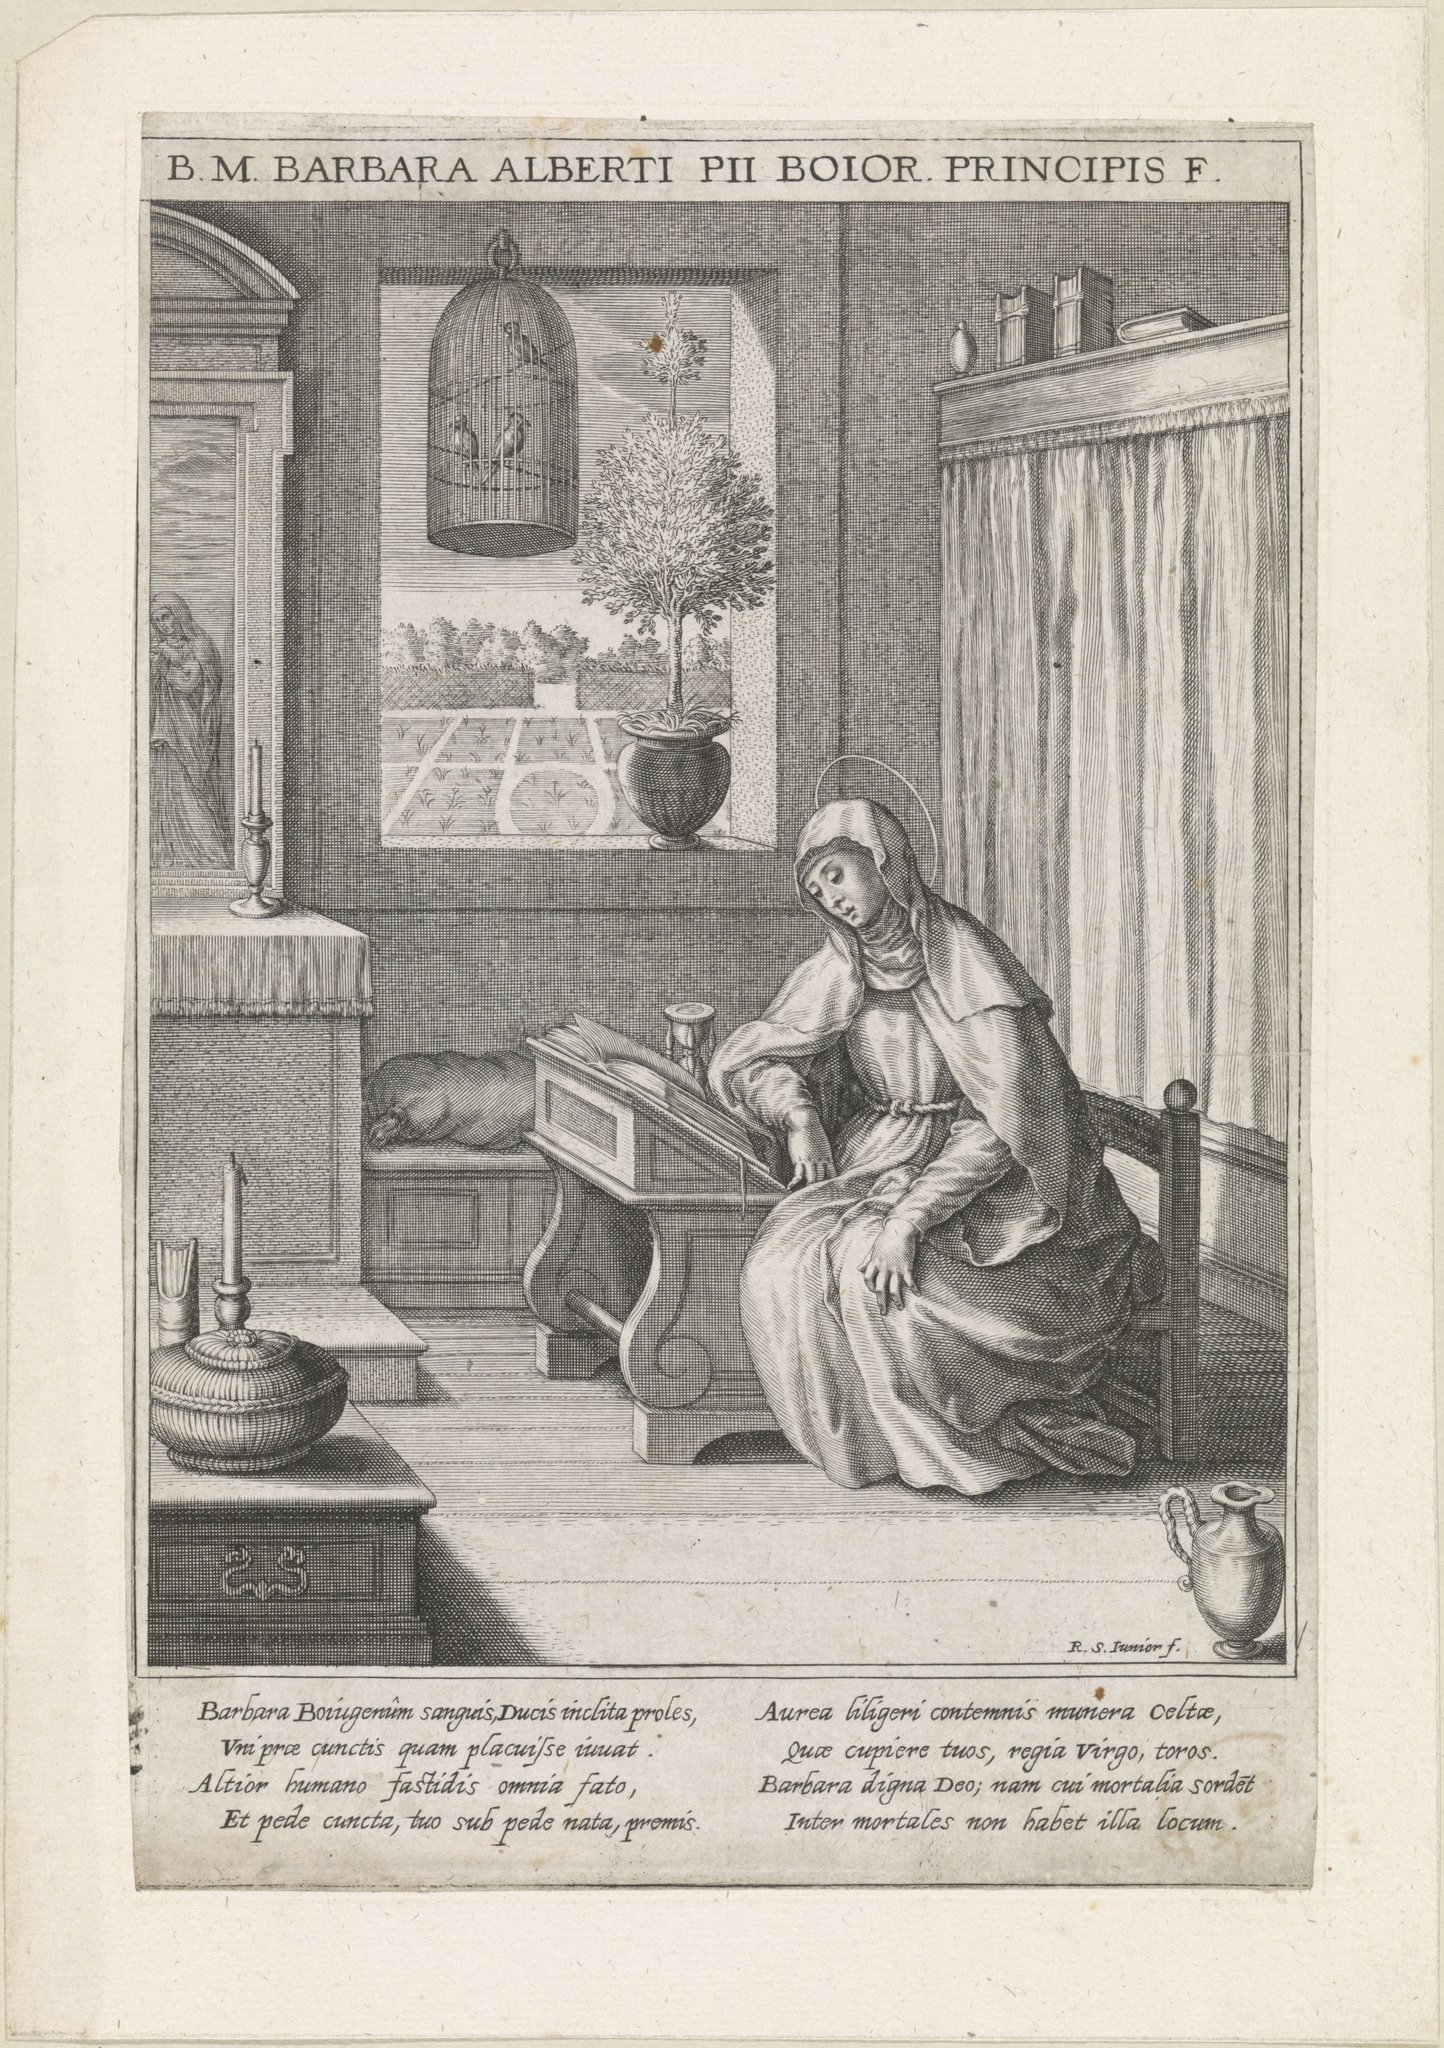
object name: print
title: B.M. Barbara Alberti PII Boior. Principis F.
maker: raphaël sadeler (ii)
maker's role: print maker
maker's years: 1584-1632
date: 1627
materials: paper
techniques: engraving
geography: munich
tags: reading, nun(s), cloisters ~ monastery, bird in a cage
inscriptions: collector's mark: Lugt 240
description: Barbara van Beieren, dochter van de Beierse hertog Albrecht III en non van de orde der clarissen, zit in een studeerkamer van het Angerklooster in München en leest en boek. Voor het open raam hangt een kooi met vogels. Door het raam een zicht op de kloostertuin. De prent heeft een Latijns onderschrift.